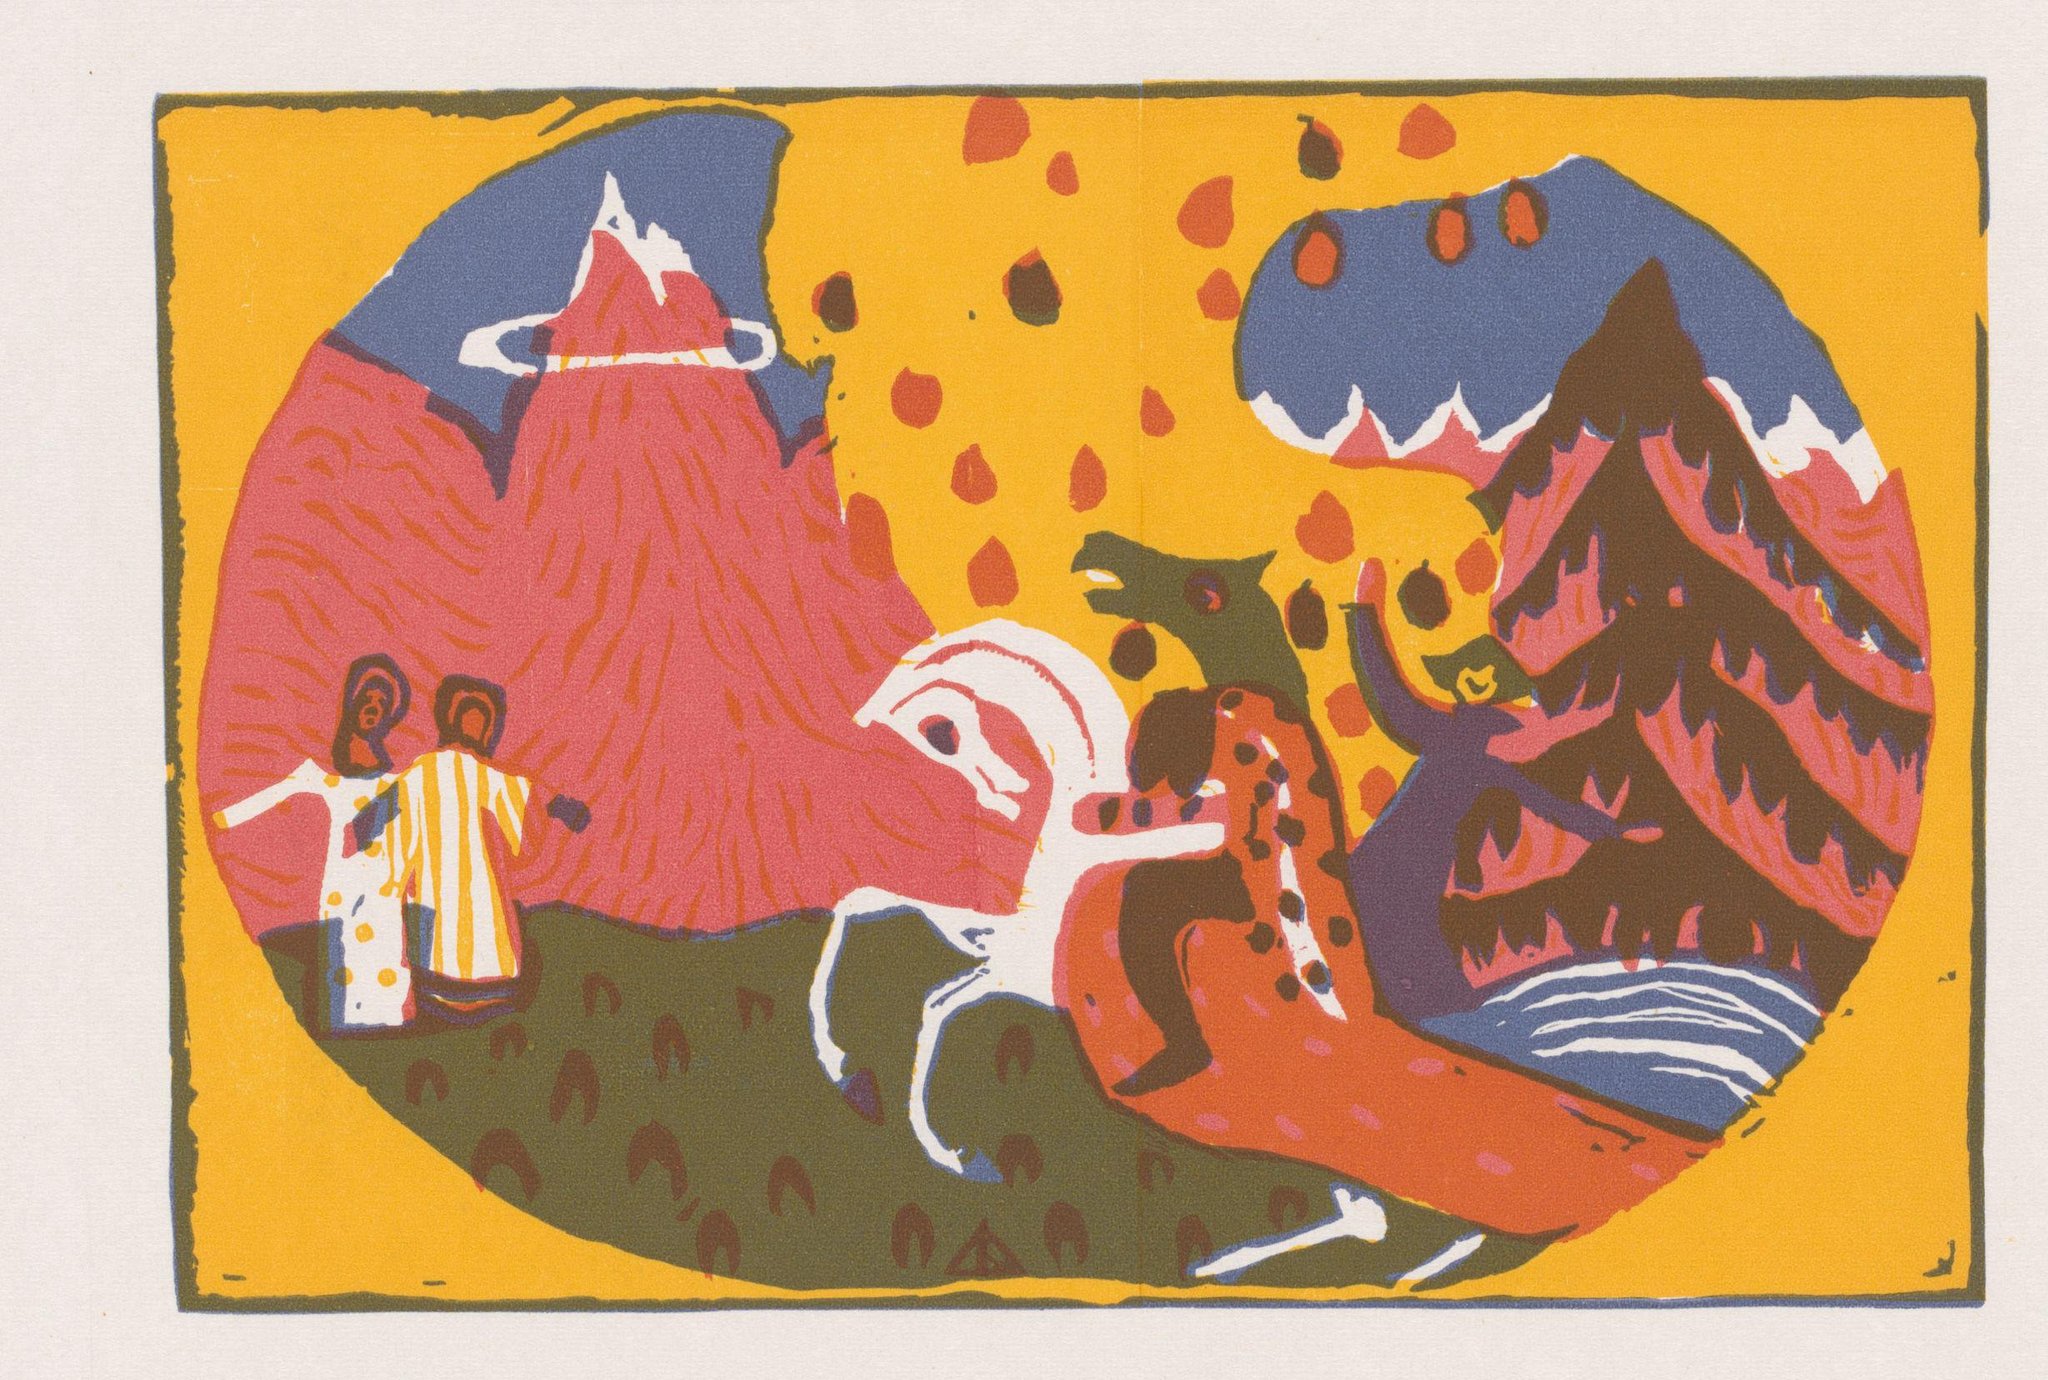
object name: reproduction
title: Bergen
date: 1966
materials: paper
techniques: printing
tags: riding a horse, ass, or mule; rider, horseman, monsters of mixed human and animal shape; 'mostri' (ripa), mountains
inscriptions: caption: ‘Kandinsky. Gravure sur bois en trois couleurs pour <<Klänge>>. (Bois originaux de l'edition Piper, 1913).’, collector's mark: Lugt 2228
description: Deze reproductie is waarschijnlijk afkomstig uit het tijdschrift 'XXe siècle', uitgegeven in 1966.